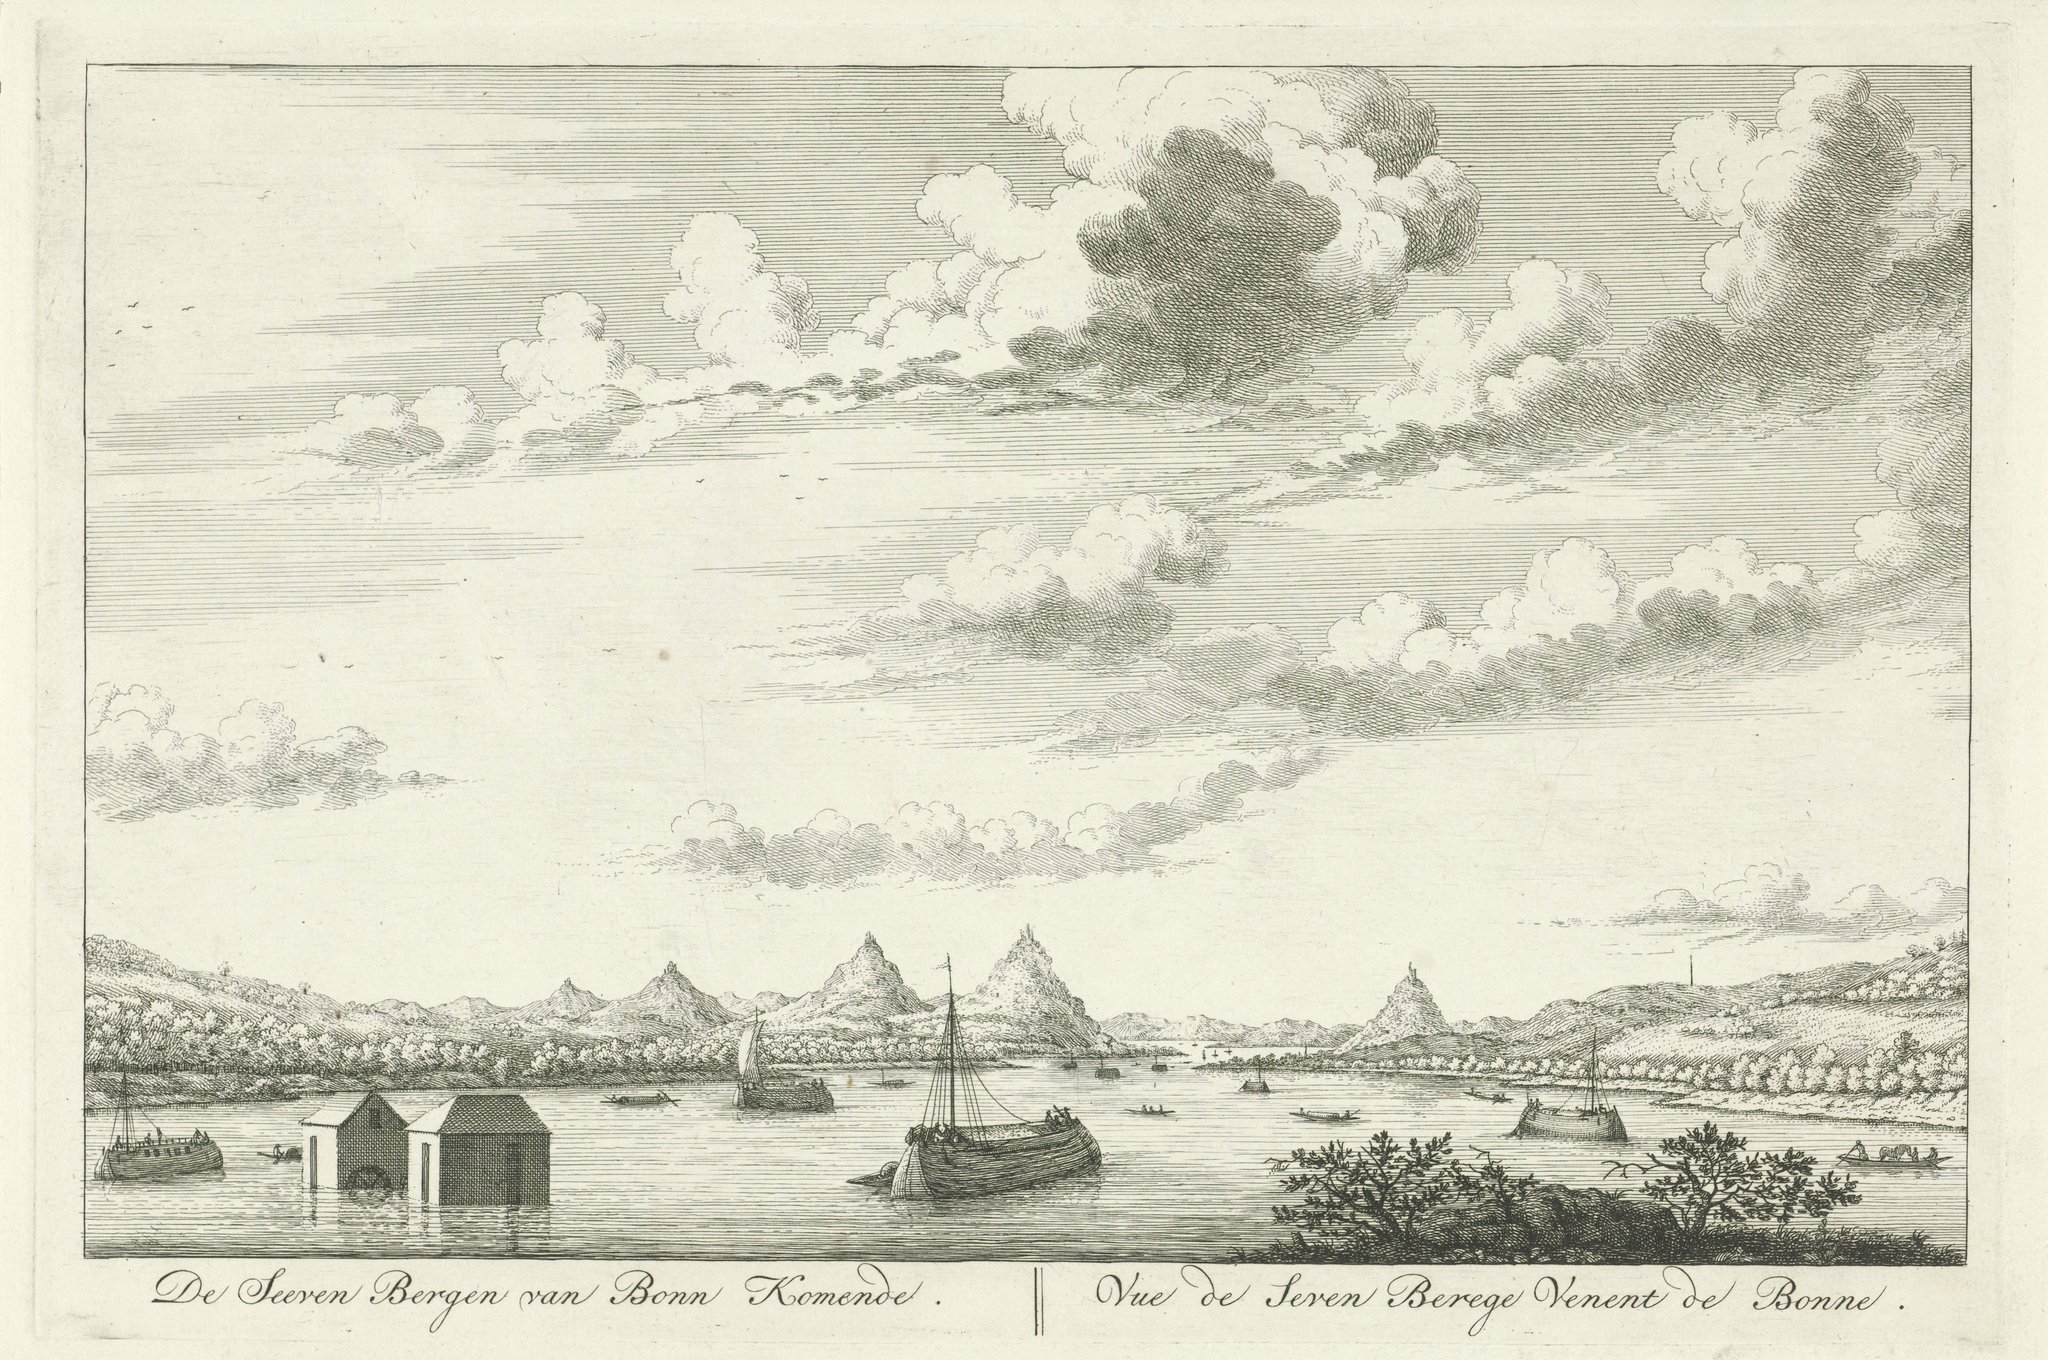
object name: print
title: De Seeven Bergen van Bonn Komende / Vue de Seven Berege Venent de Bonne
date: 1767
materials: paper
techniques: etching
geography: amsterdam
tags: low hill country, river, ships (in general)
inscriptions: collector's mark: Lugt 2228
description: Gezicht op het Zevengebergte, gezien vanaf de Rijn. De prent maakt deel uit van een elfdelige serie prenten met gezichten langs de Rijn.